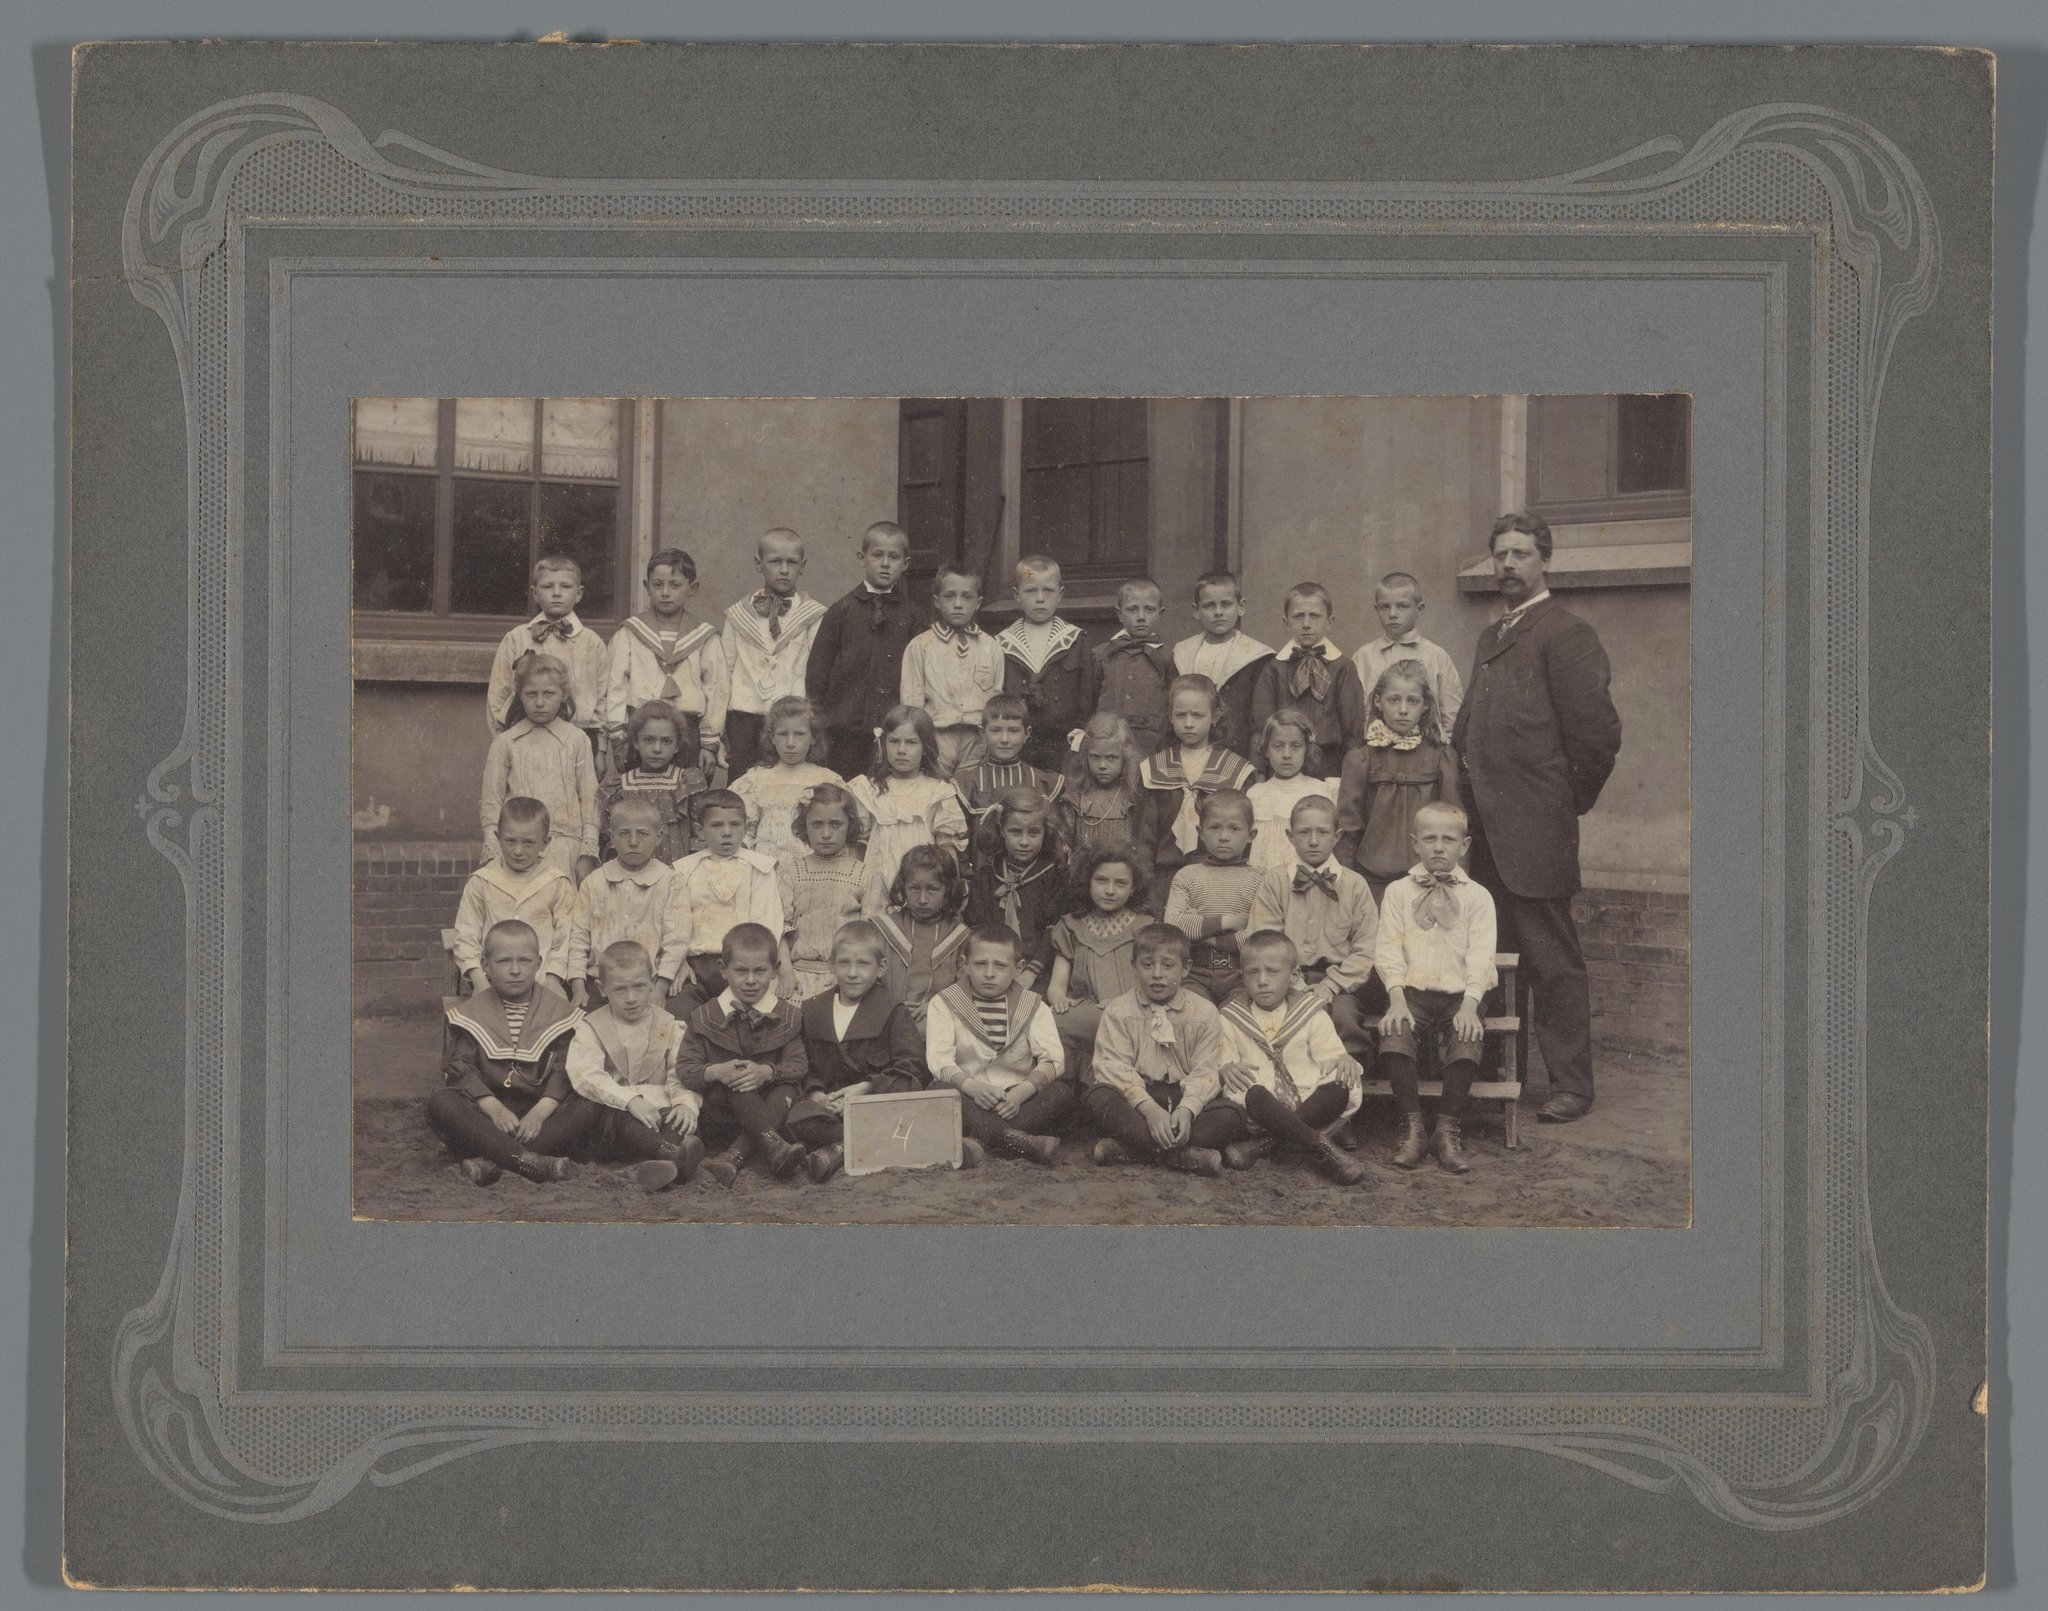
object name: photograph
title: Groepsportret van een onbekende schoolklas met jongens en meisjes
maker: p.d. van rhijn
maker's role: fotograaf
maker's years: 1874-1942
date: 1891-1918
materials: paper, cardboard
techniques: matte daylight collodion silver print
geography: amsterdam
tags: boy (child between toddler and youth), teacher and pupil, girl (child between toddler and youth), anonymous historical persons portrayed in a group, in a group-portrait, amsterdam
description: Op RP-F-F20575 is dezelfde leraar gefotografeerd, de foto is ook op dezelfde plek genomen.